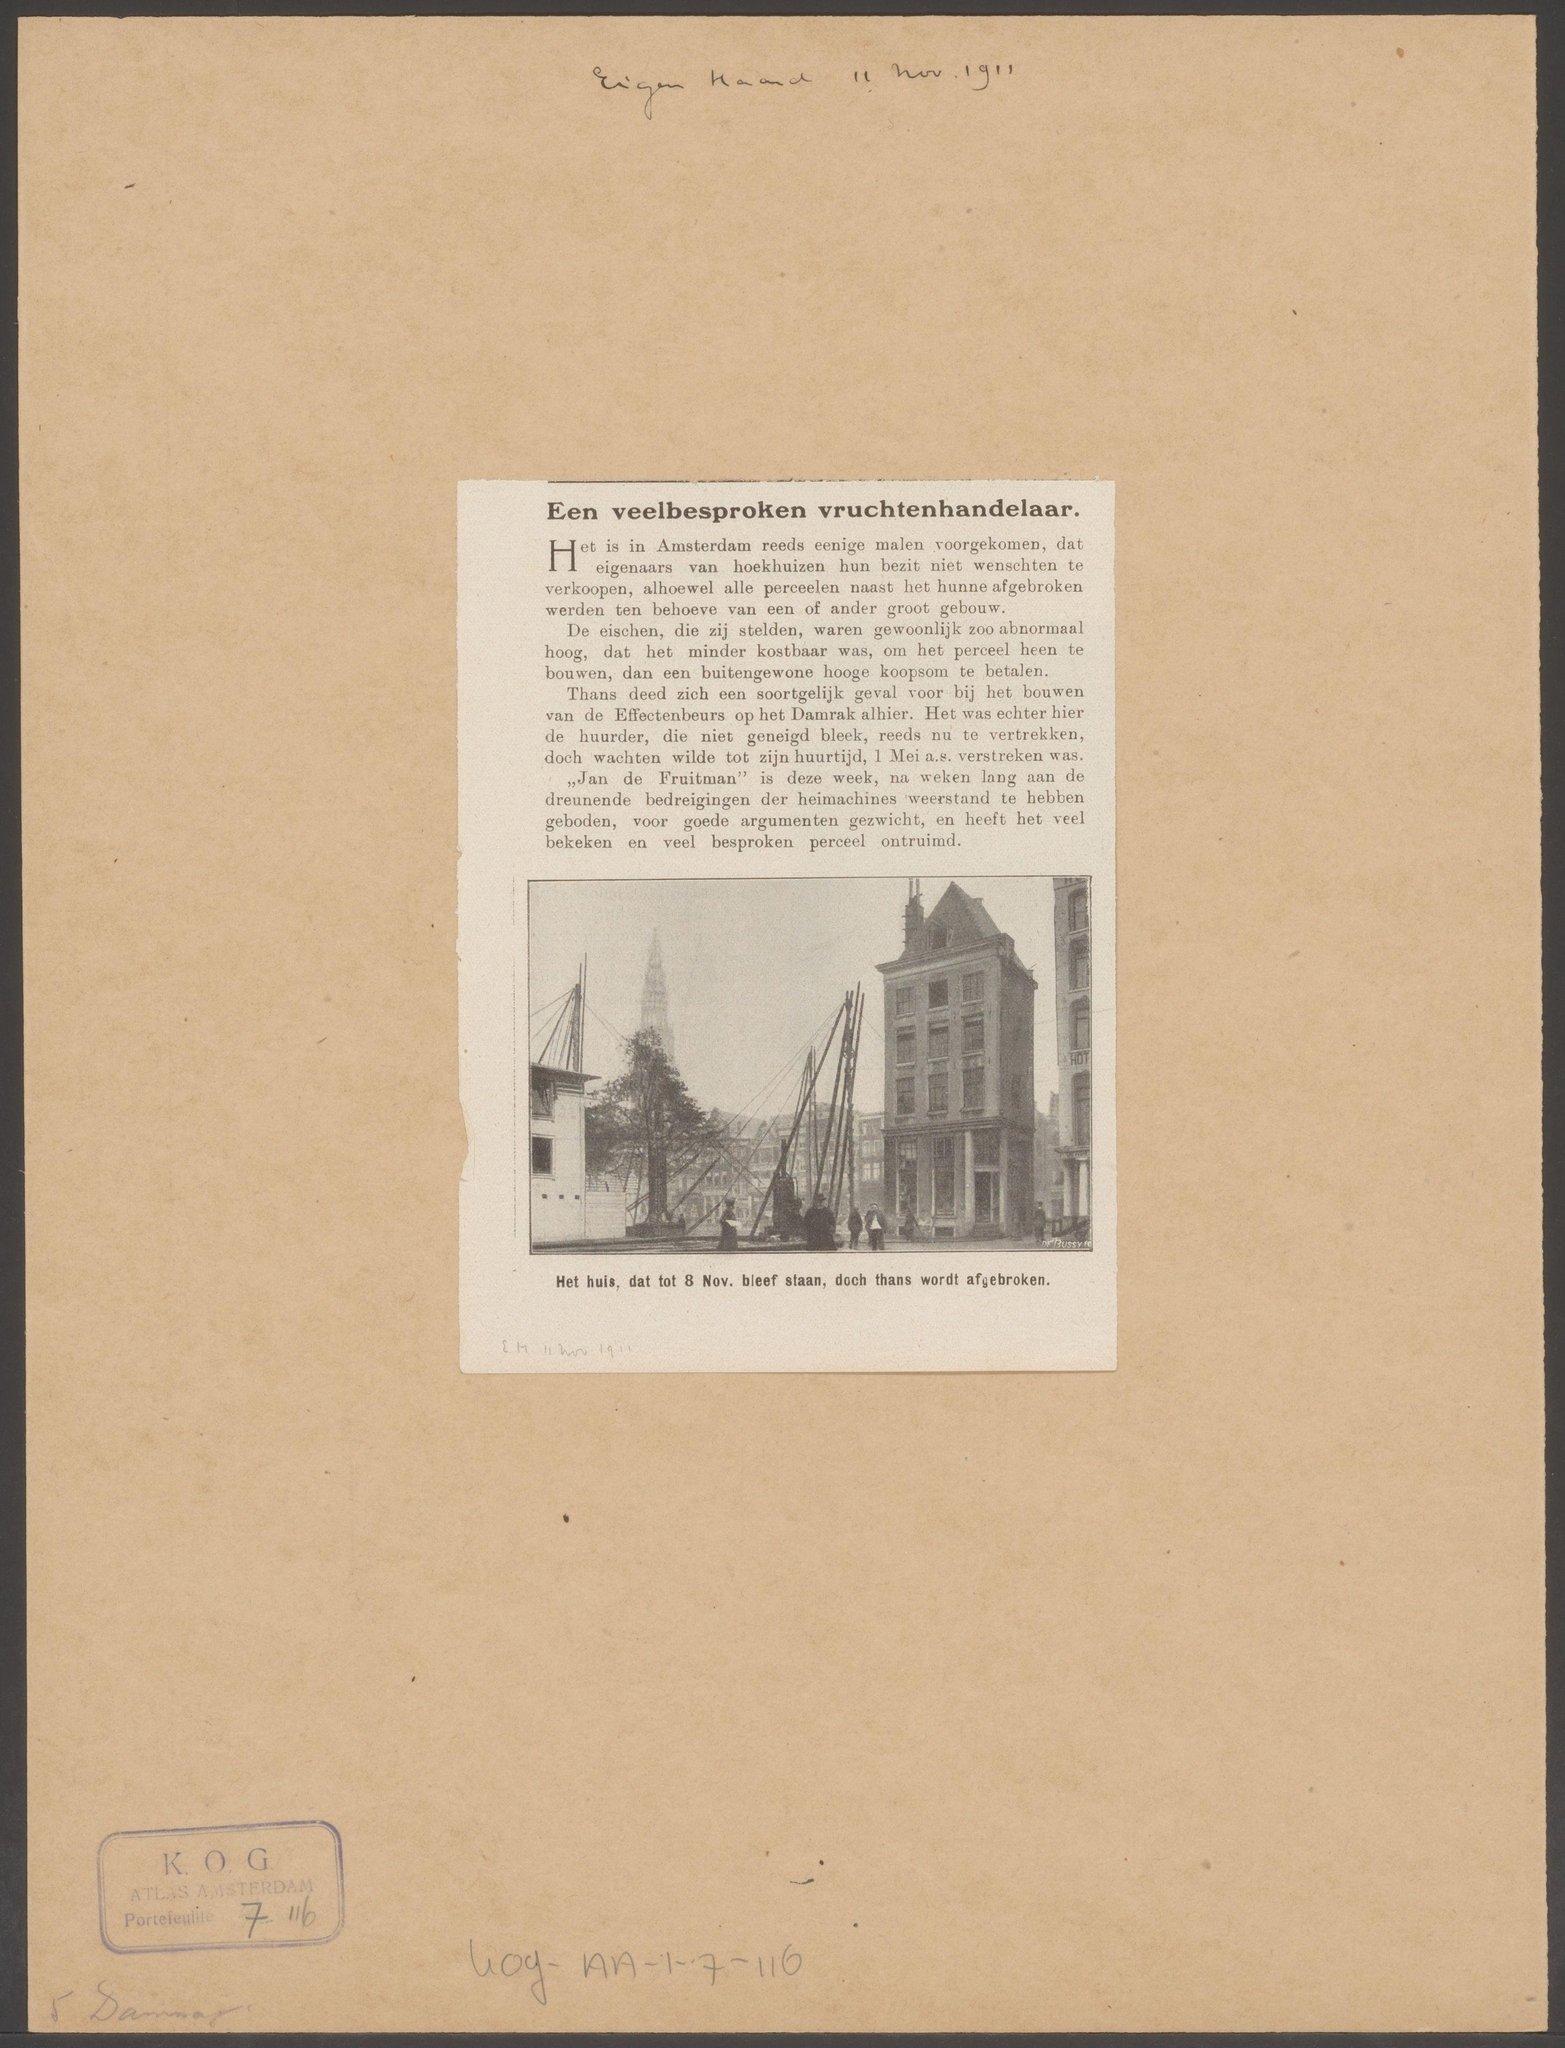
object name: photomechanical print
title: Gezicht op een te slopen pand op het Damrak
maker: Anonymous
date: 1911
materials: paper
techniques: letterpress printing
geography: haarlem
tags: city-view in general; 'veduta', parts of church exterior and annexes: spire, façade (of house or building)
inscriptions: collector's mark: ‘7’ Lugt 1641b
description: Onderwerpsrubriek binnen de Atlas Amsterdam: Damrak, Damstraat, Doelensluis, Doelenstraat (Nieuwe), Driehoekstraat, Droogbak, Duvelshoek, Dijkstraat en Korte -.